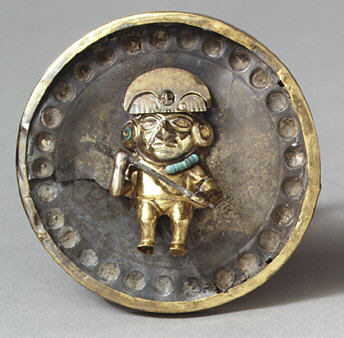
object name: earflare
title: Earflare, Warrior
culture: moche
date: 390-450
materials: gold, silver, stone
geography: peru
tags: human figures